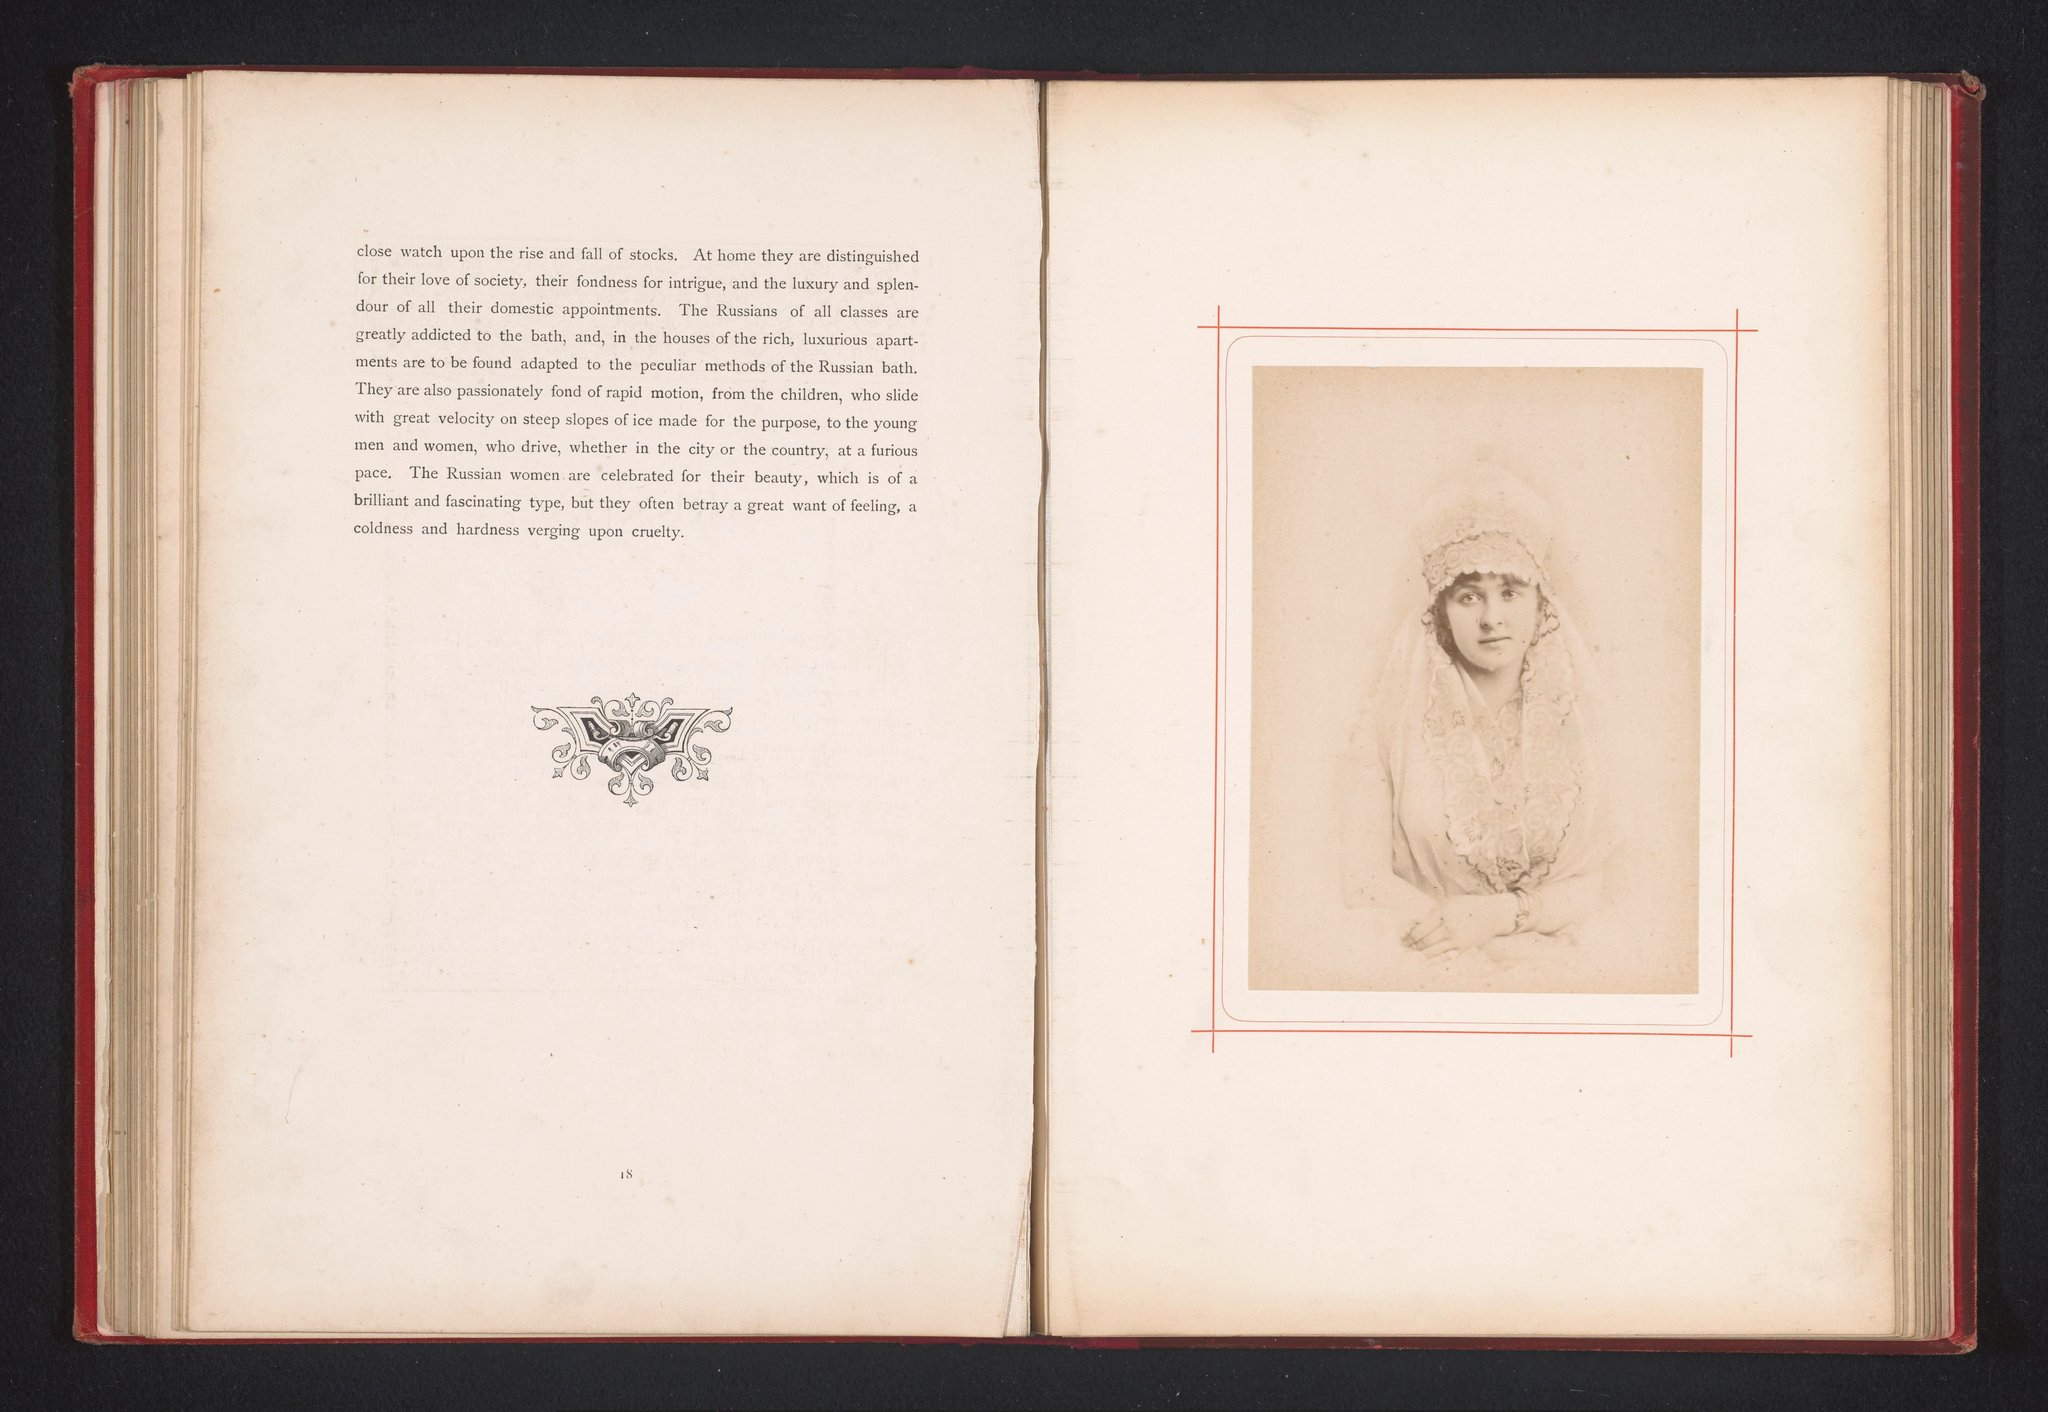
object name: photograph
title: Portret van een onbekende vrouw in klederdracht uit Bulgarije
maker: Anonymous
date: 1876-1886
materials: photographic support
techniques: albumen print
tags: folk costume, regional costume, anonymous historical person portrayed - bb - woman